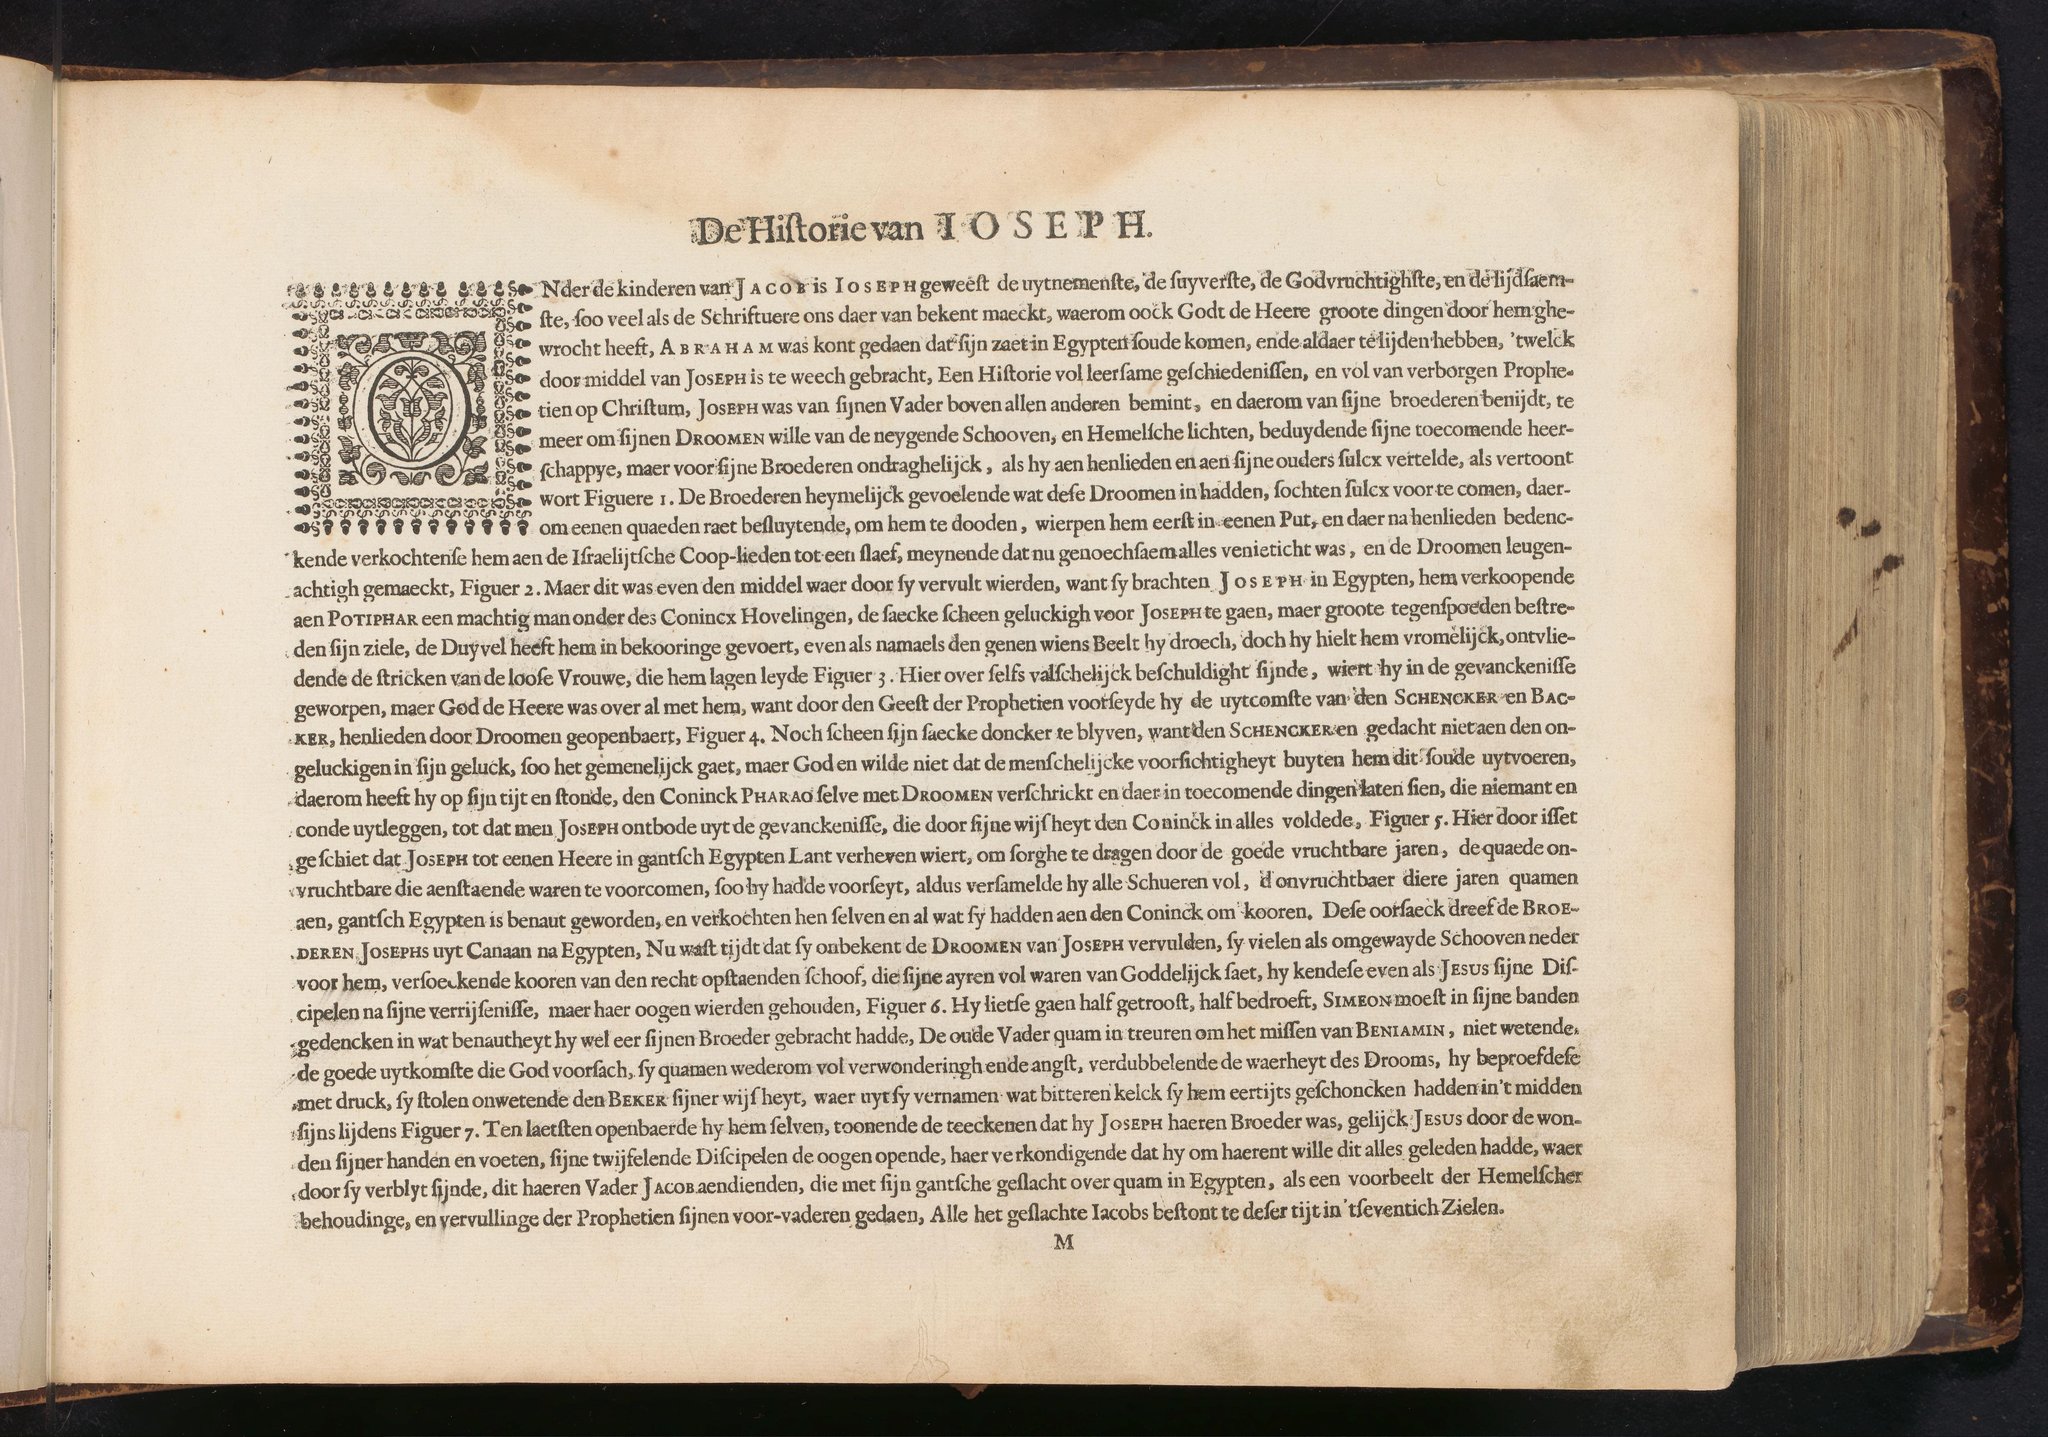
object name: album leaf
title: Den Grooten Figuer-Bibel (...)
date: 1646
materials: paper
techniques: letterpress printing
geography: alkmaar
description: Tekstblad bij een serie prenten over de geschiedenis van Jozef. Dit blad maakt deel uit van een album.